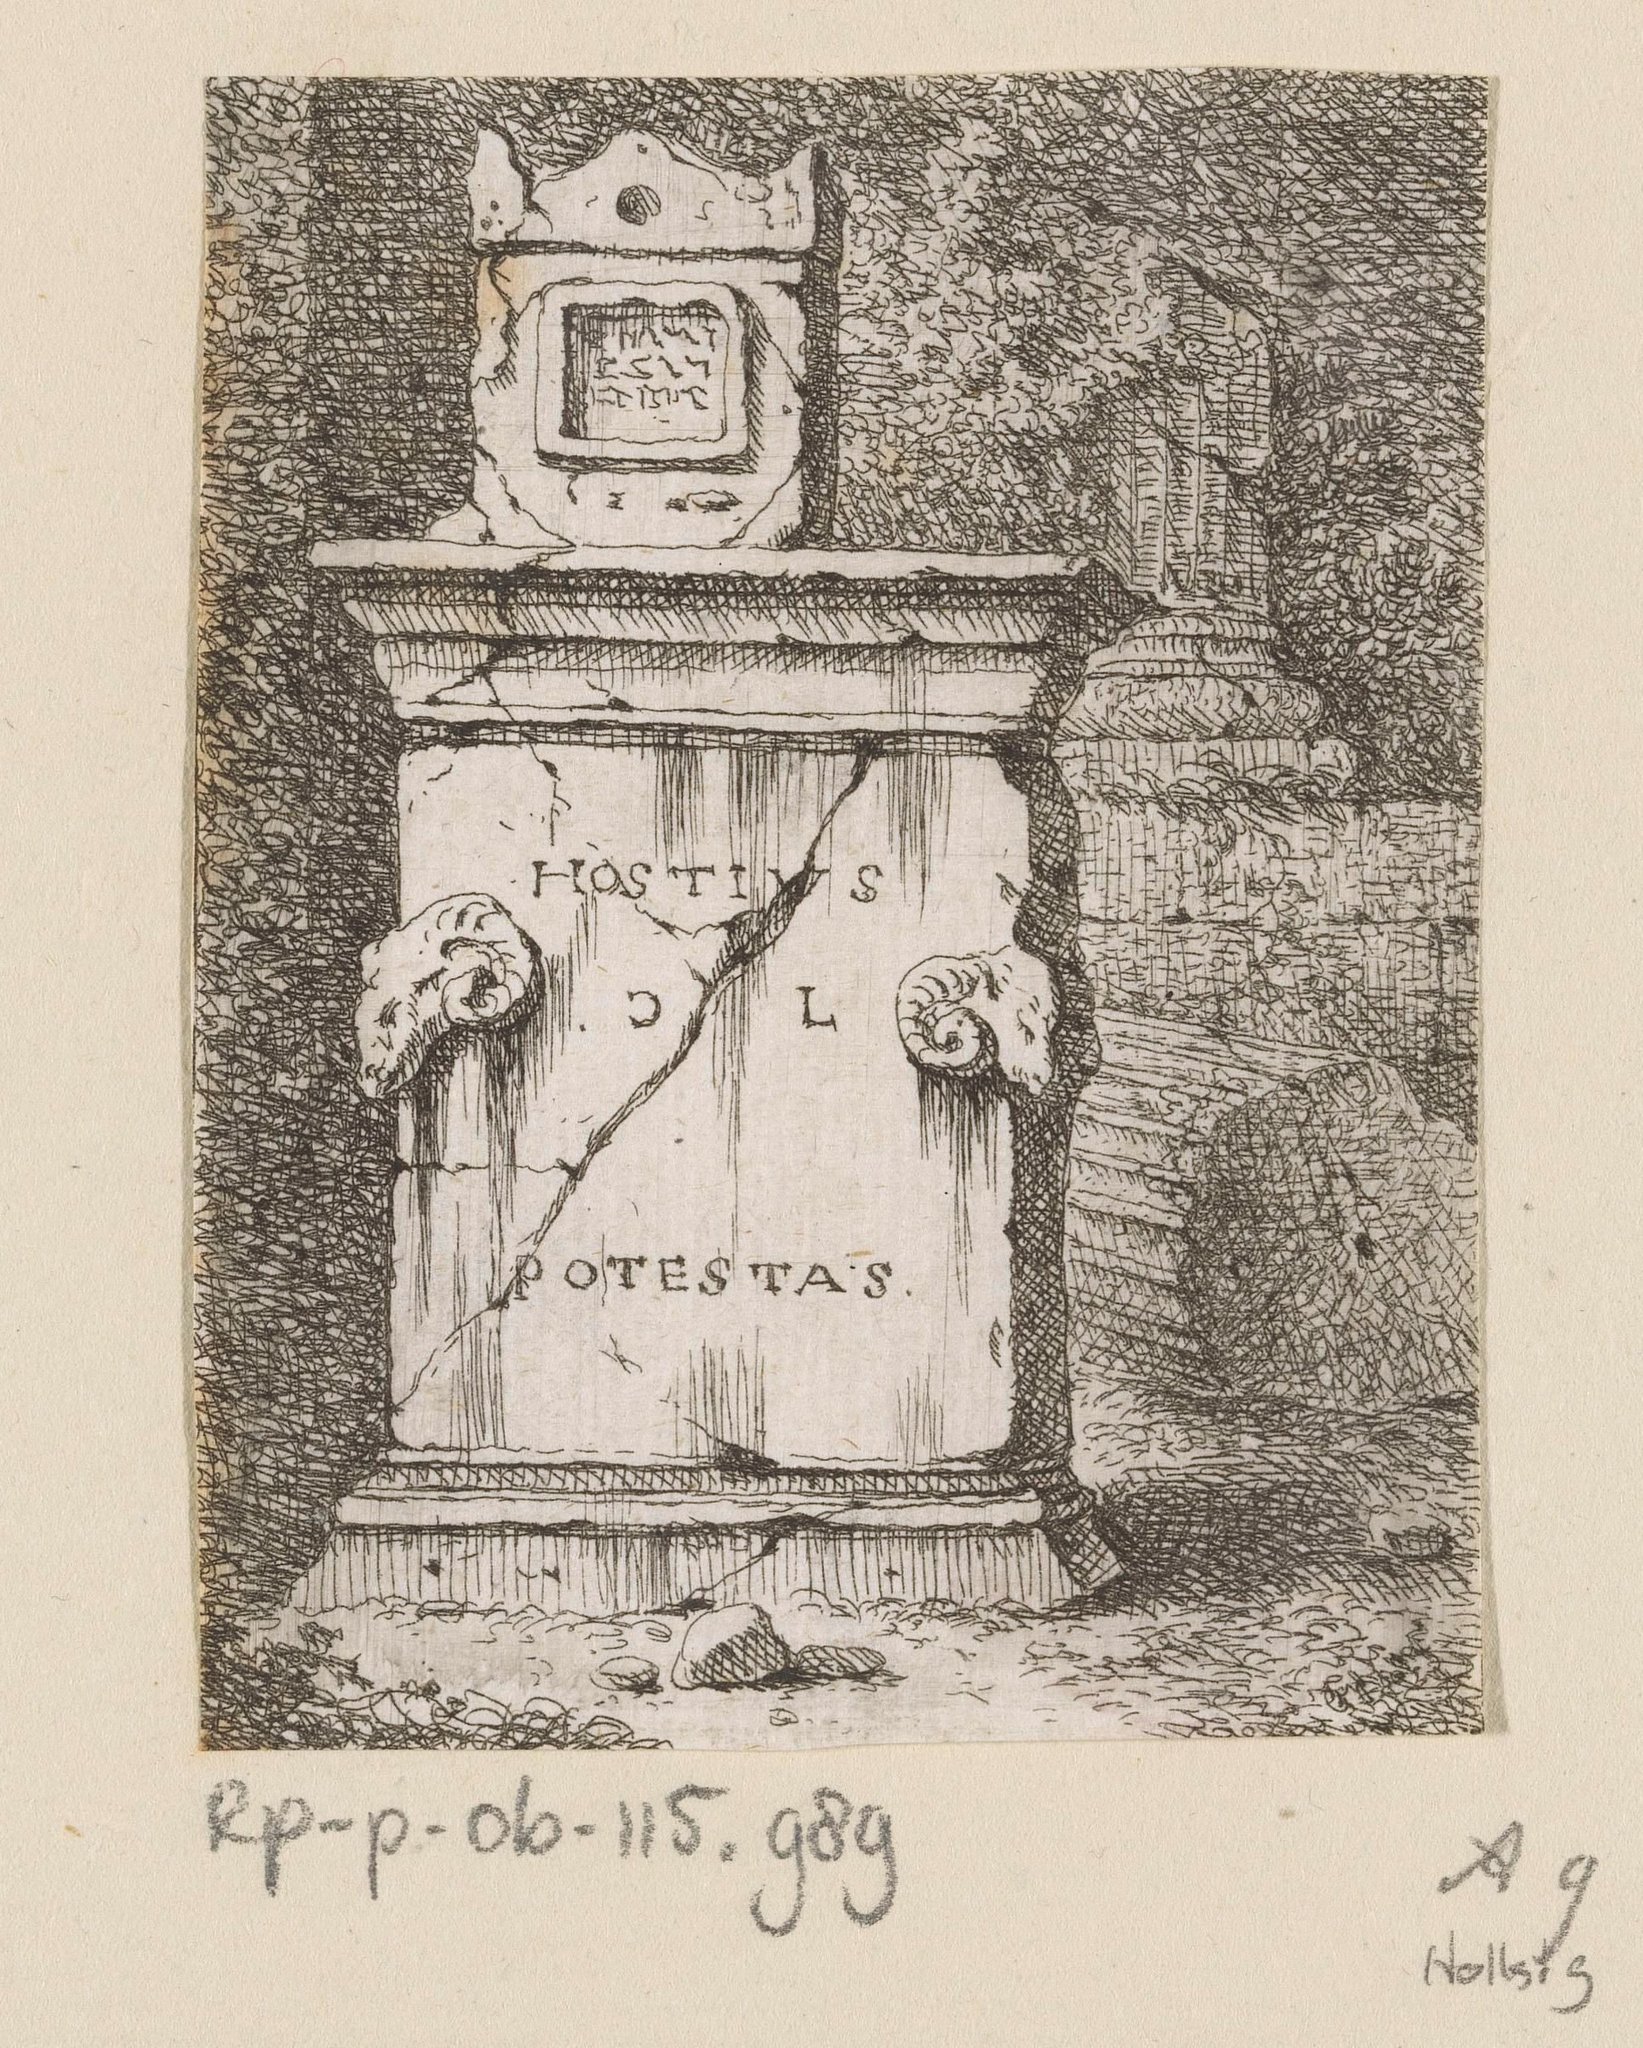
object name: print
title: Romeinse ruïnes en monumenten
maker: johann franz ermels (der ältere)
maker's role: draughtsman, print maker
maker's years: 1641-1693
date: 1651-1693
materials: paper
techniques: etching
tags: ram's head ~ ornament, 12ff62 altar ~ roman religion - ff - in the open air, landscape with ruins, rome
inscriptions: collector's mark: Lugt 240